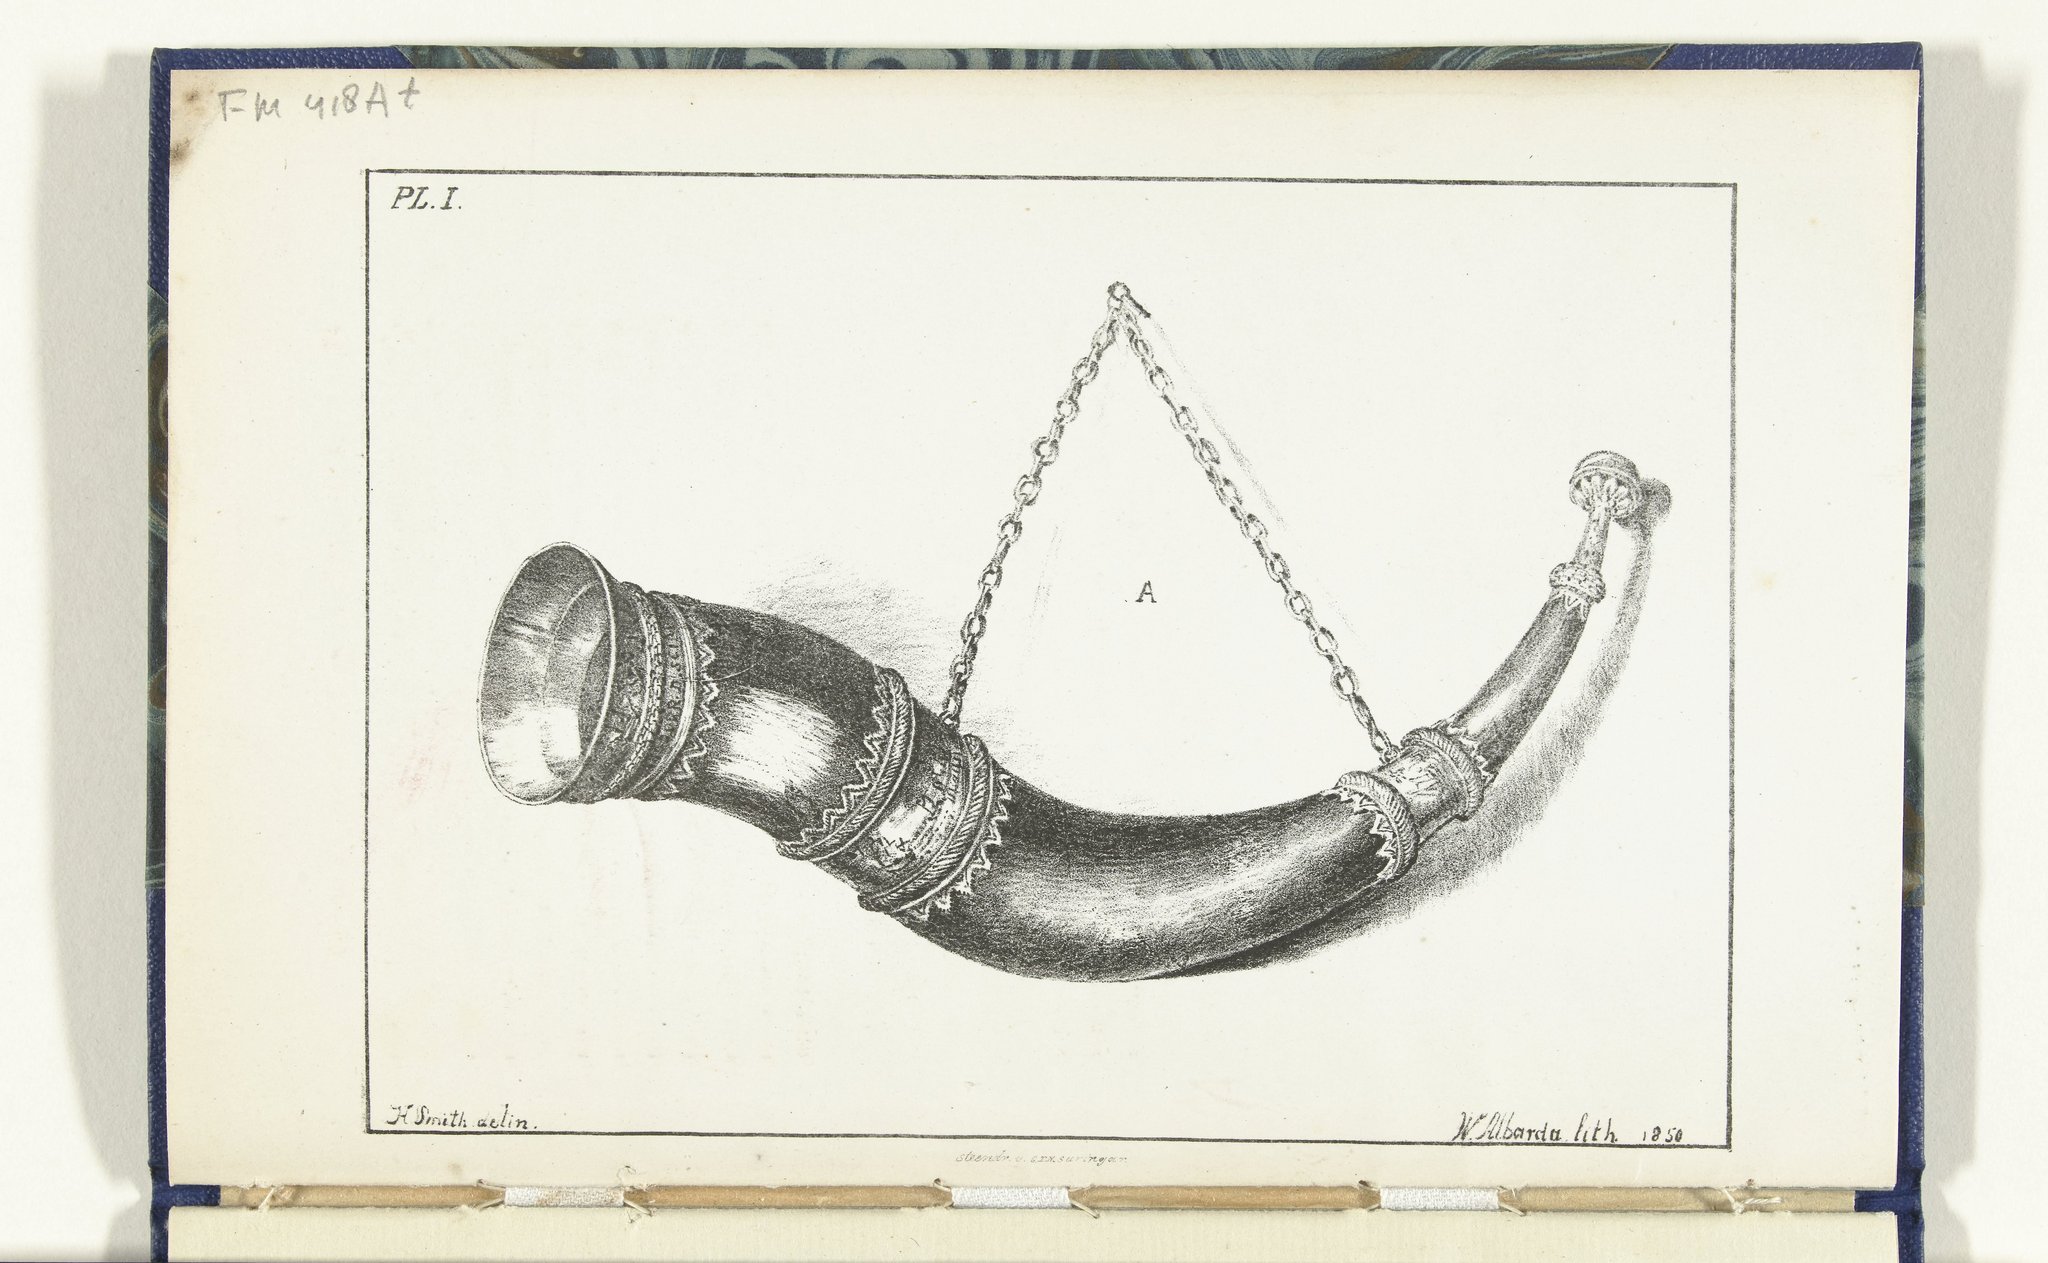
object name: print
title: Gildehoorn van het Grootveerschippers Gild te Harlingen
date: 1850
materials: paper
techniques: lithograph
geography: netherlands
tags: corporative organization, guild, drinking-horn, harlingen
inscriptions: date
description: Gildehoorn van het Grootveerschippers Gild te Harlingen. Drinkhoren in 1550 in eigendom van het gilde, in 1627 voorzien van de zilveren banden.